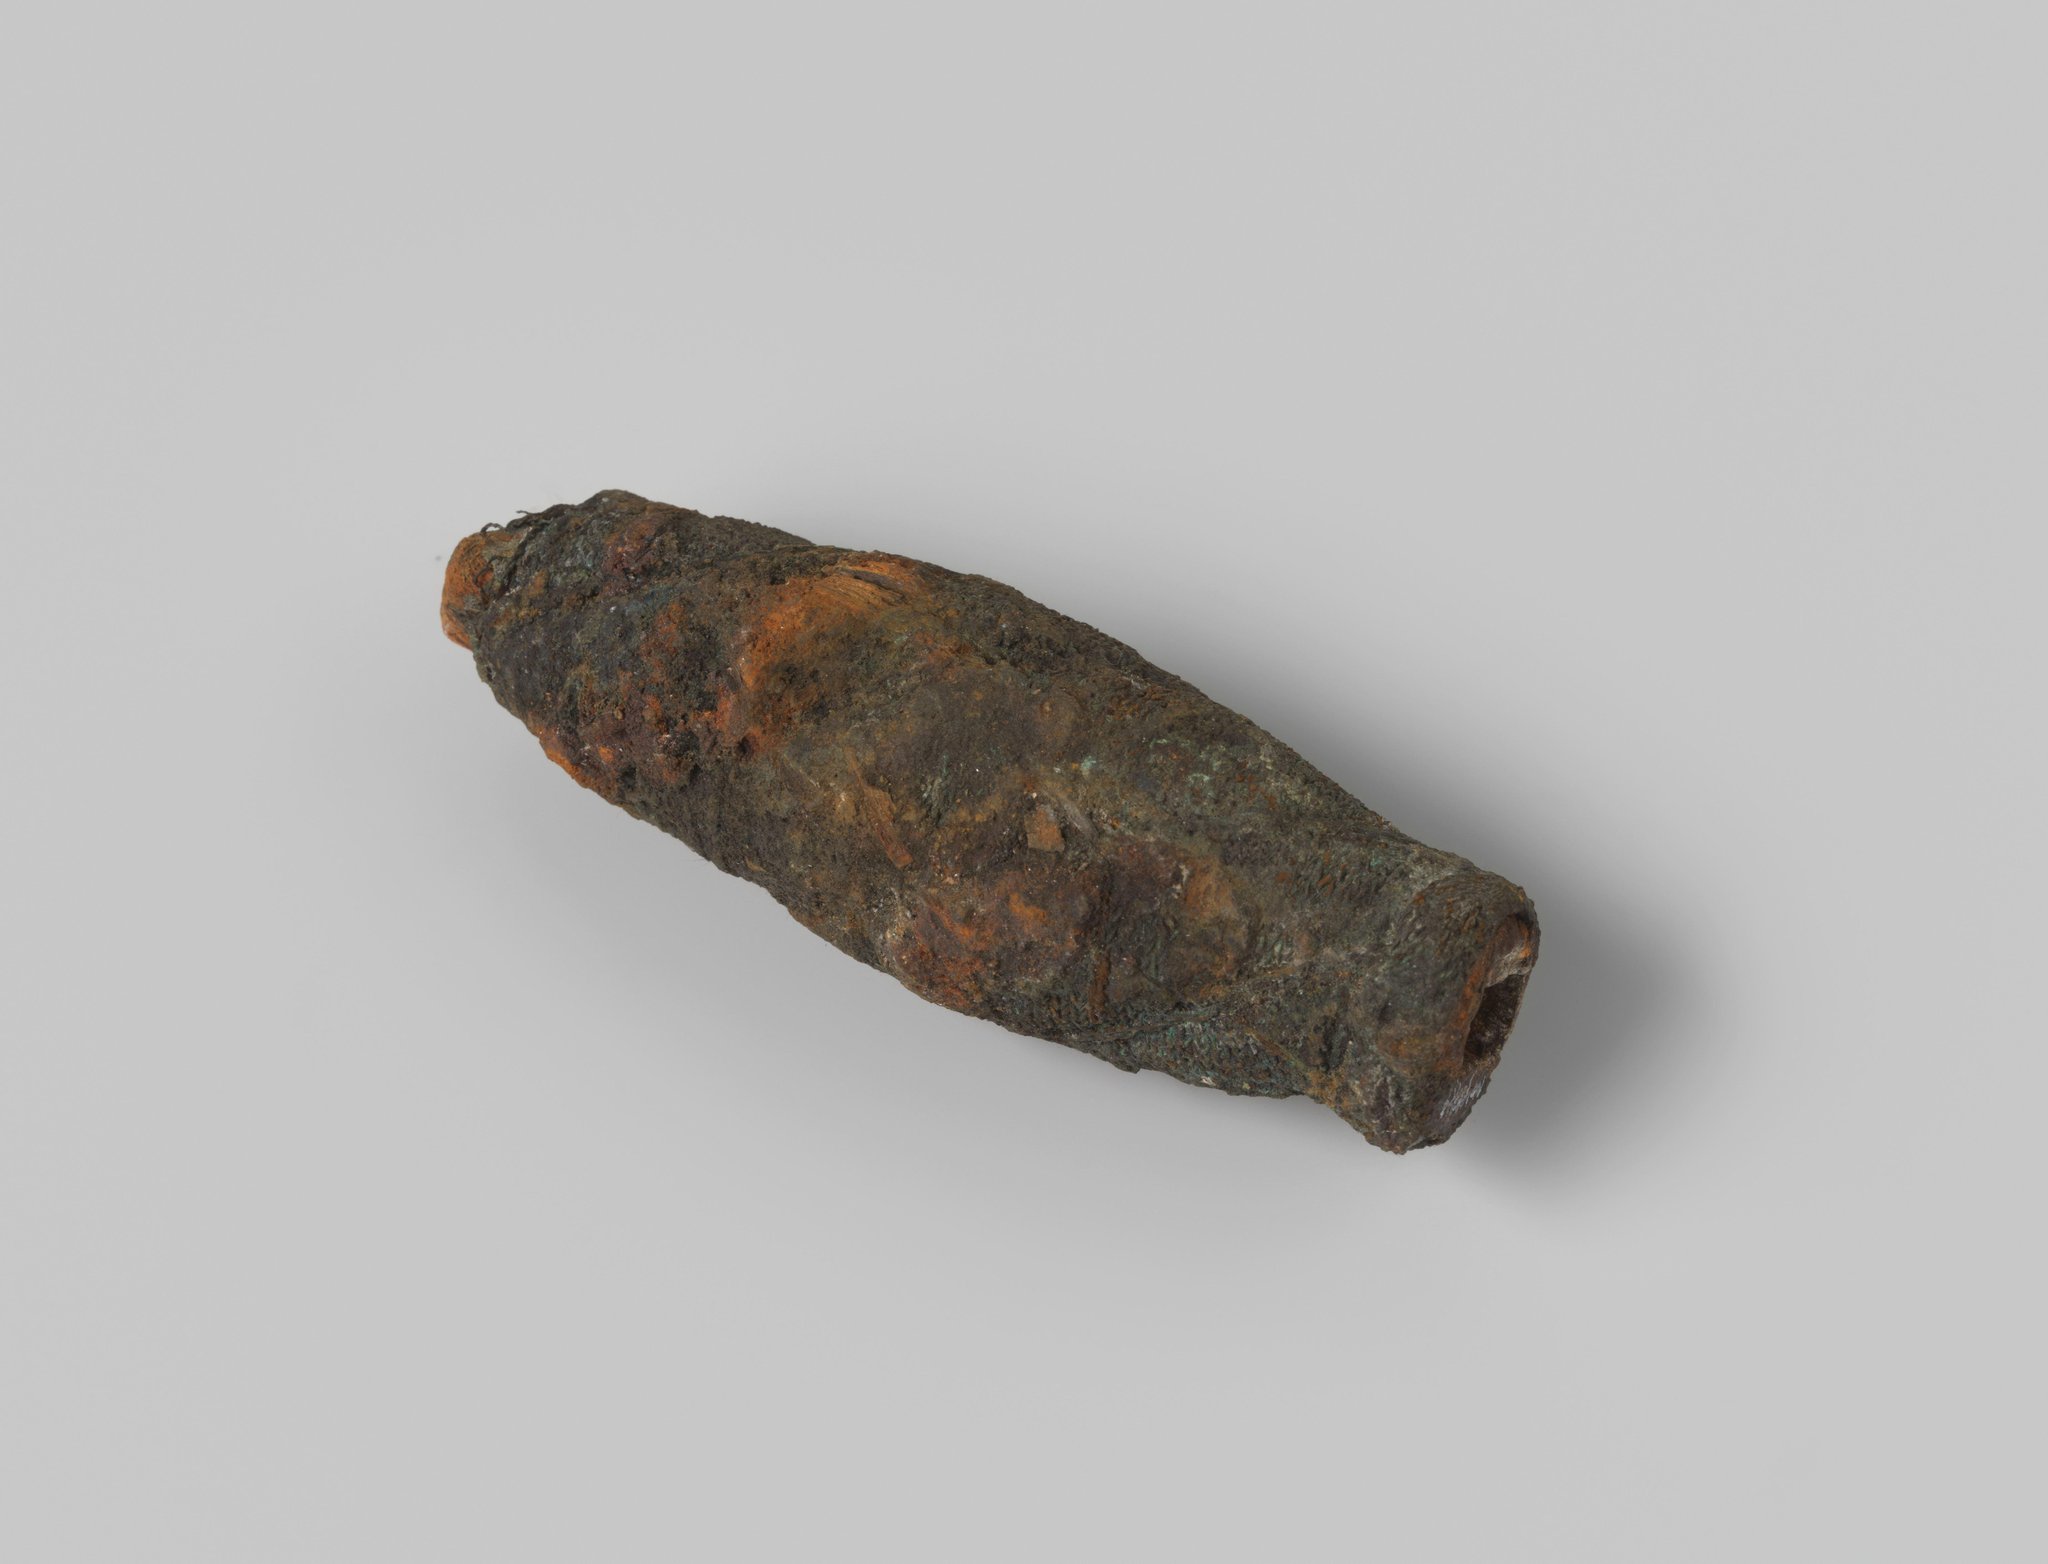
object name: greep gevest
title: Greep van een gevest uit het wrak van de Oost-Indiëvaarder Hollandia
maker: Anonymous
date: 1700-1743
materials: copper, wood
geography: netherlands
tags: verenigde oostindische compagnie, hollandia (schip), annet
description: Hilt, grip; id. NG 1980-27H2582, 1 ferrule missing.